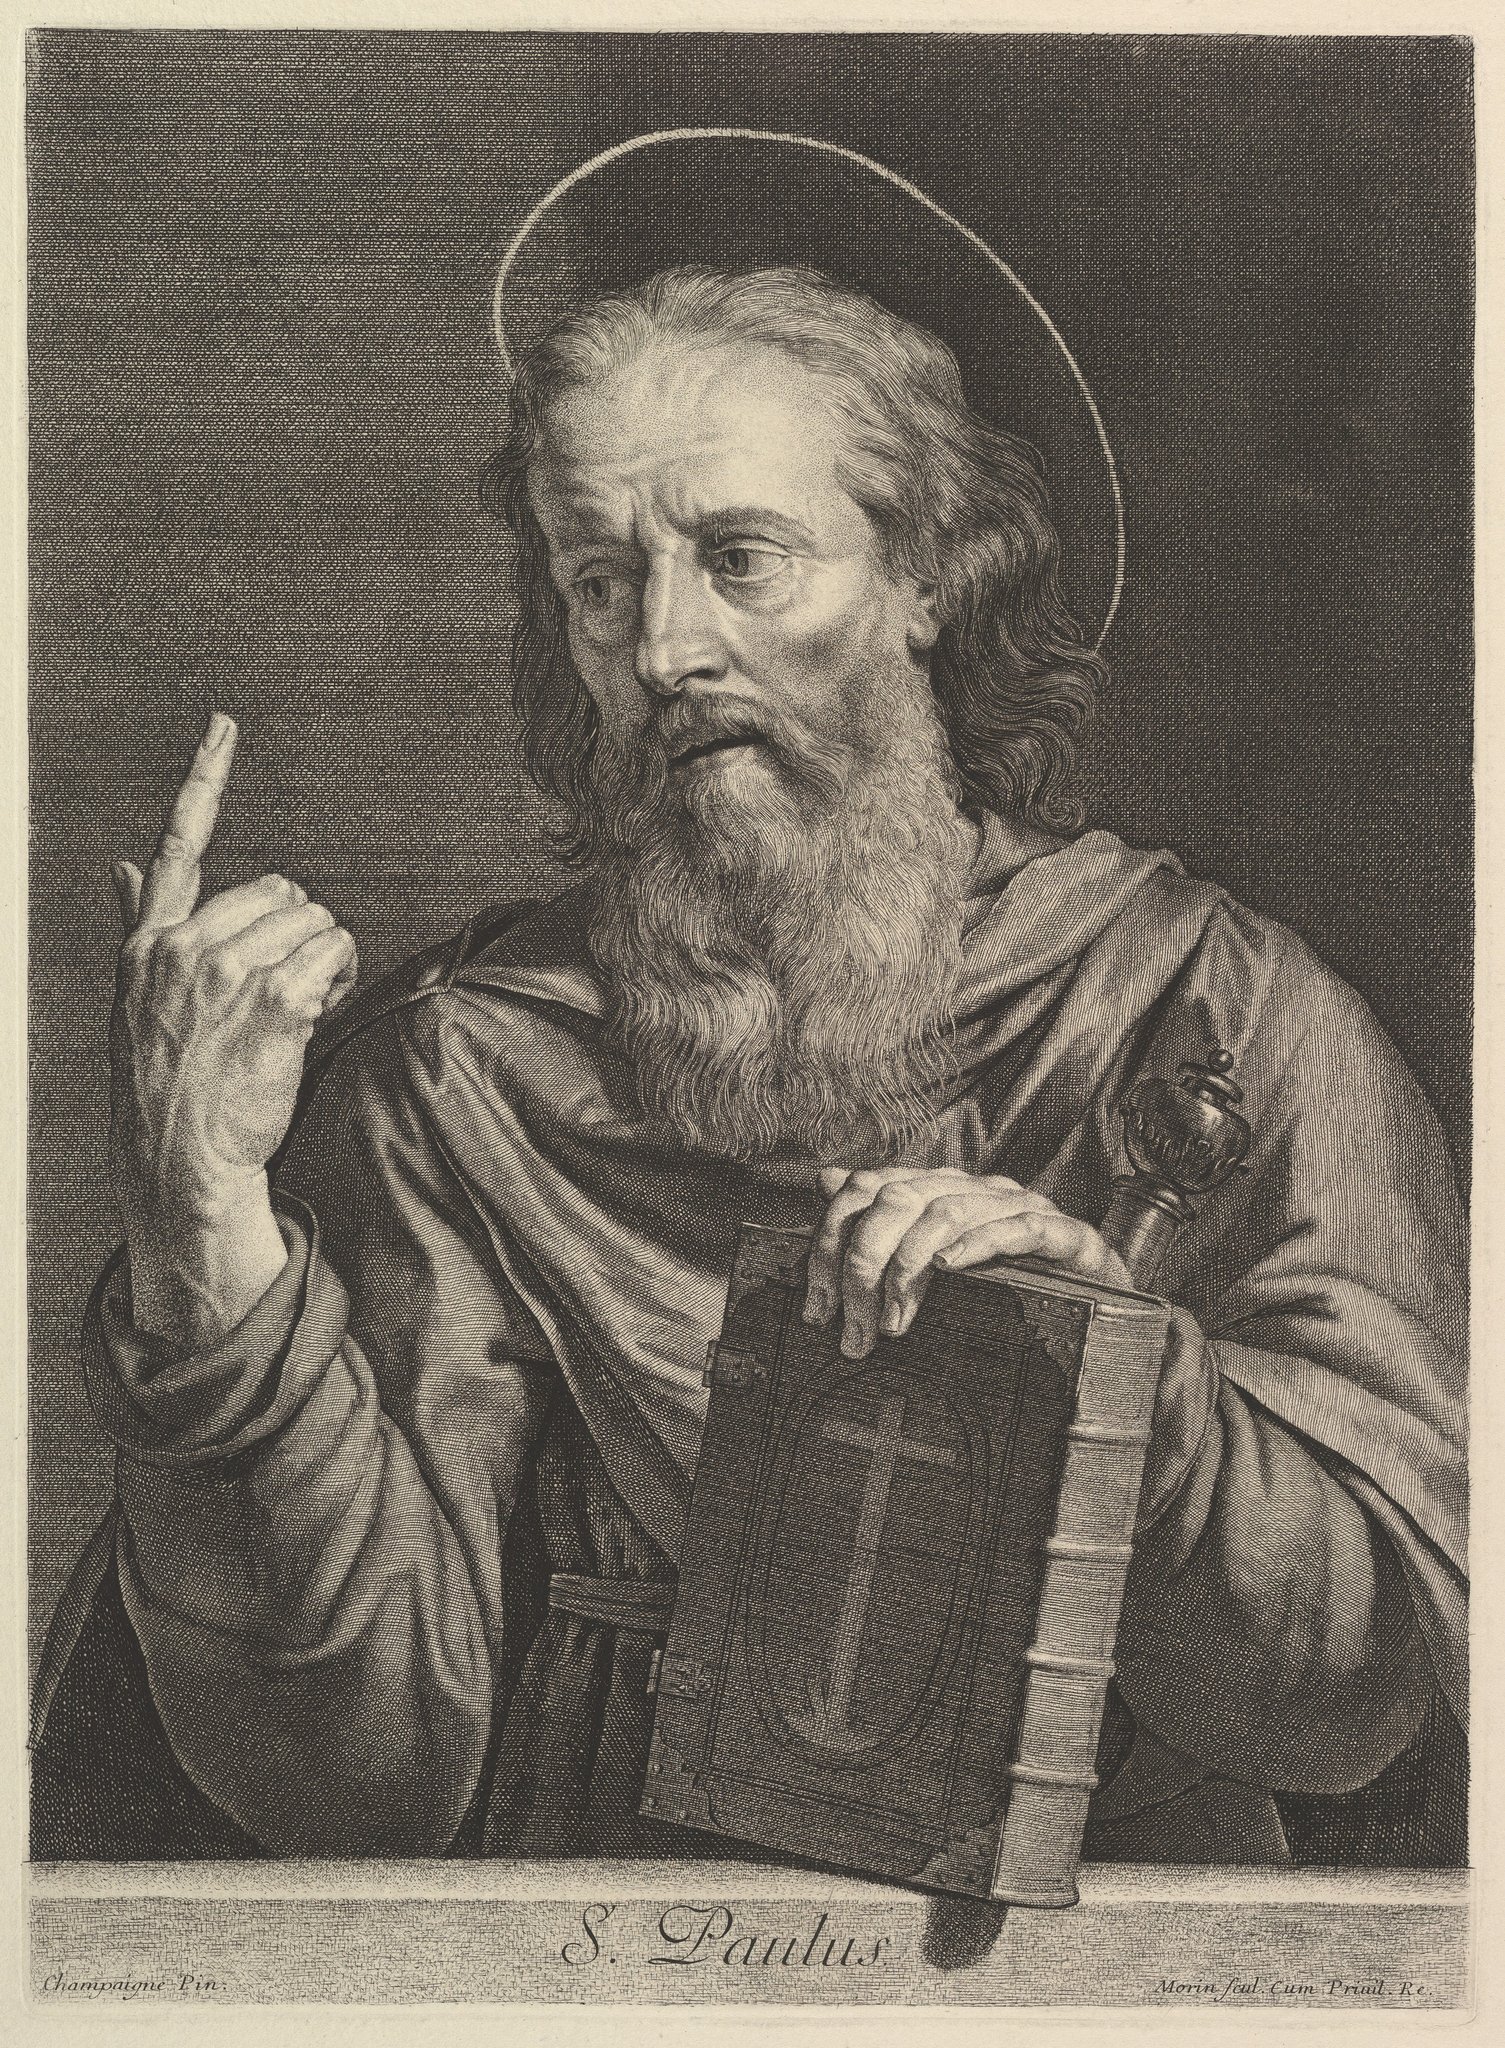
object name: print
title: Saint Paul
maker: jean morin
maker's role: artist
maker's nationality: french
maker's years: 1605-1650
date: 1605-1650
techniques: etching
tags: saint paul,cross